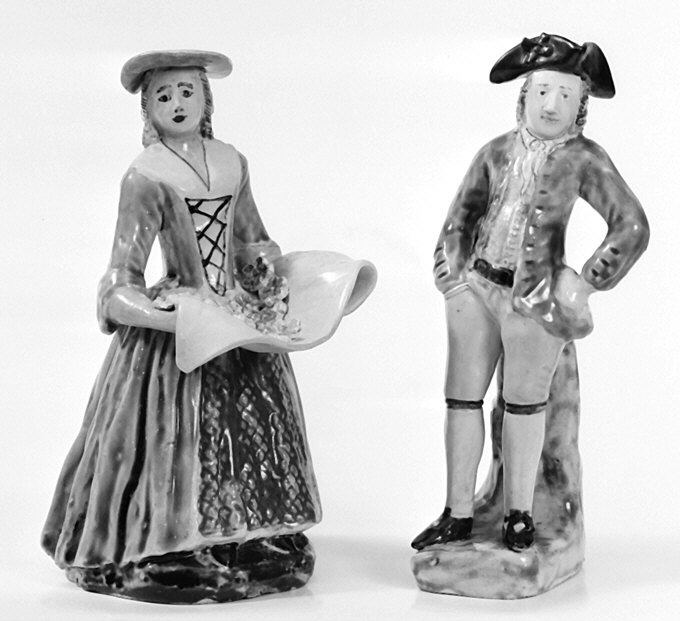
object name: figure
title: Woman and Man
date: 1760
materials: stoneware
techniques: salt glaze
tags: men,women